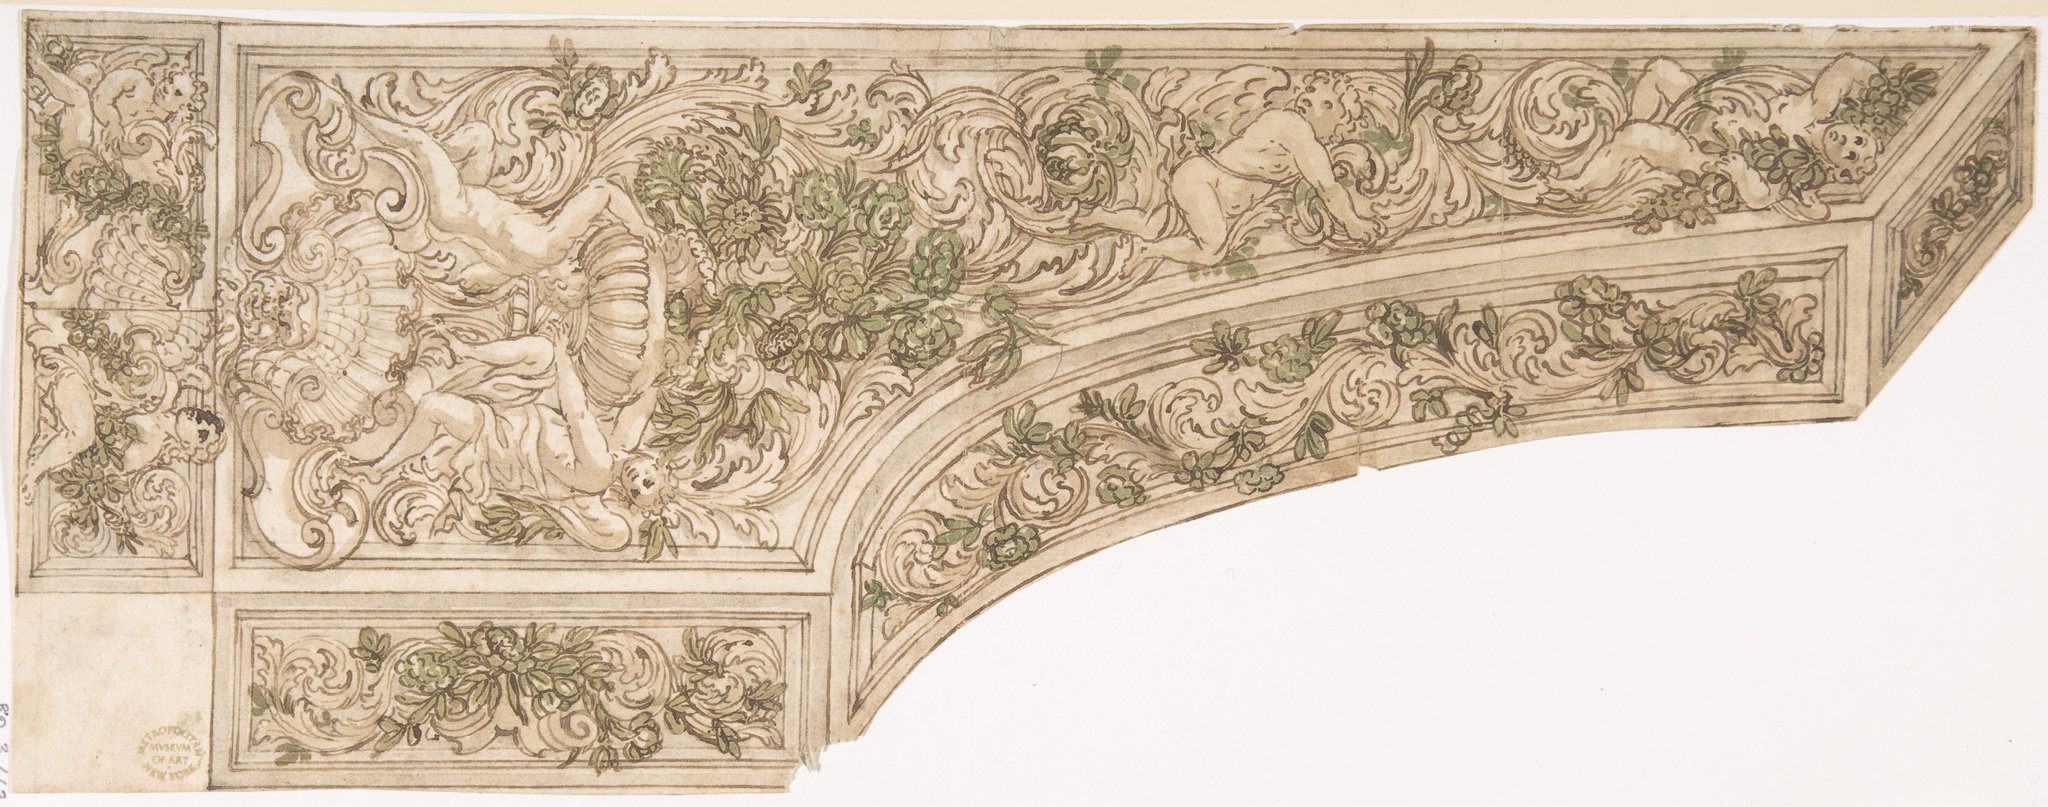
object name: drawing ornament architecture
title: Design for the Decoration of a Harpsichord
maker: anonymous, italian, roman-bolognese, 17th century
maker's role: artist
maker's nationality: italian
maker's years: 1600-1700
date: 1640-1680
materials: chalk, ink, paper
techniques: brush, pen, wash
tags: ornament,harpsichords